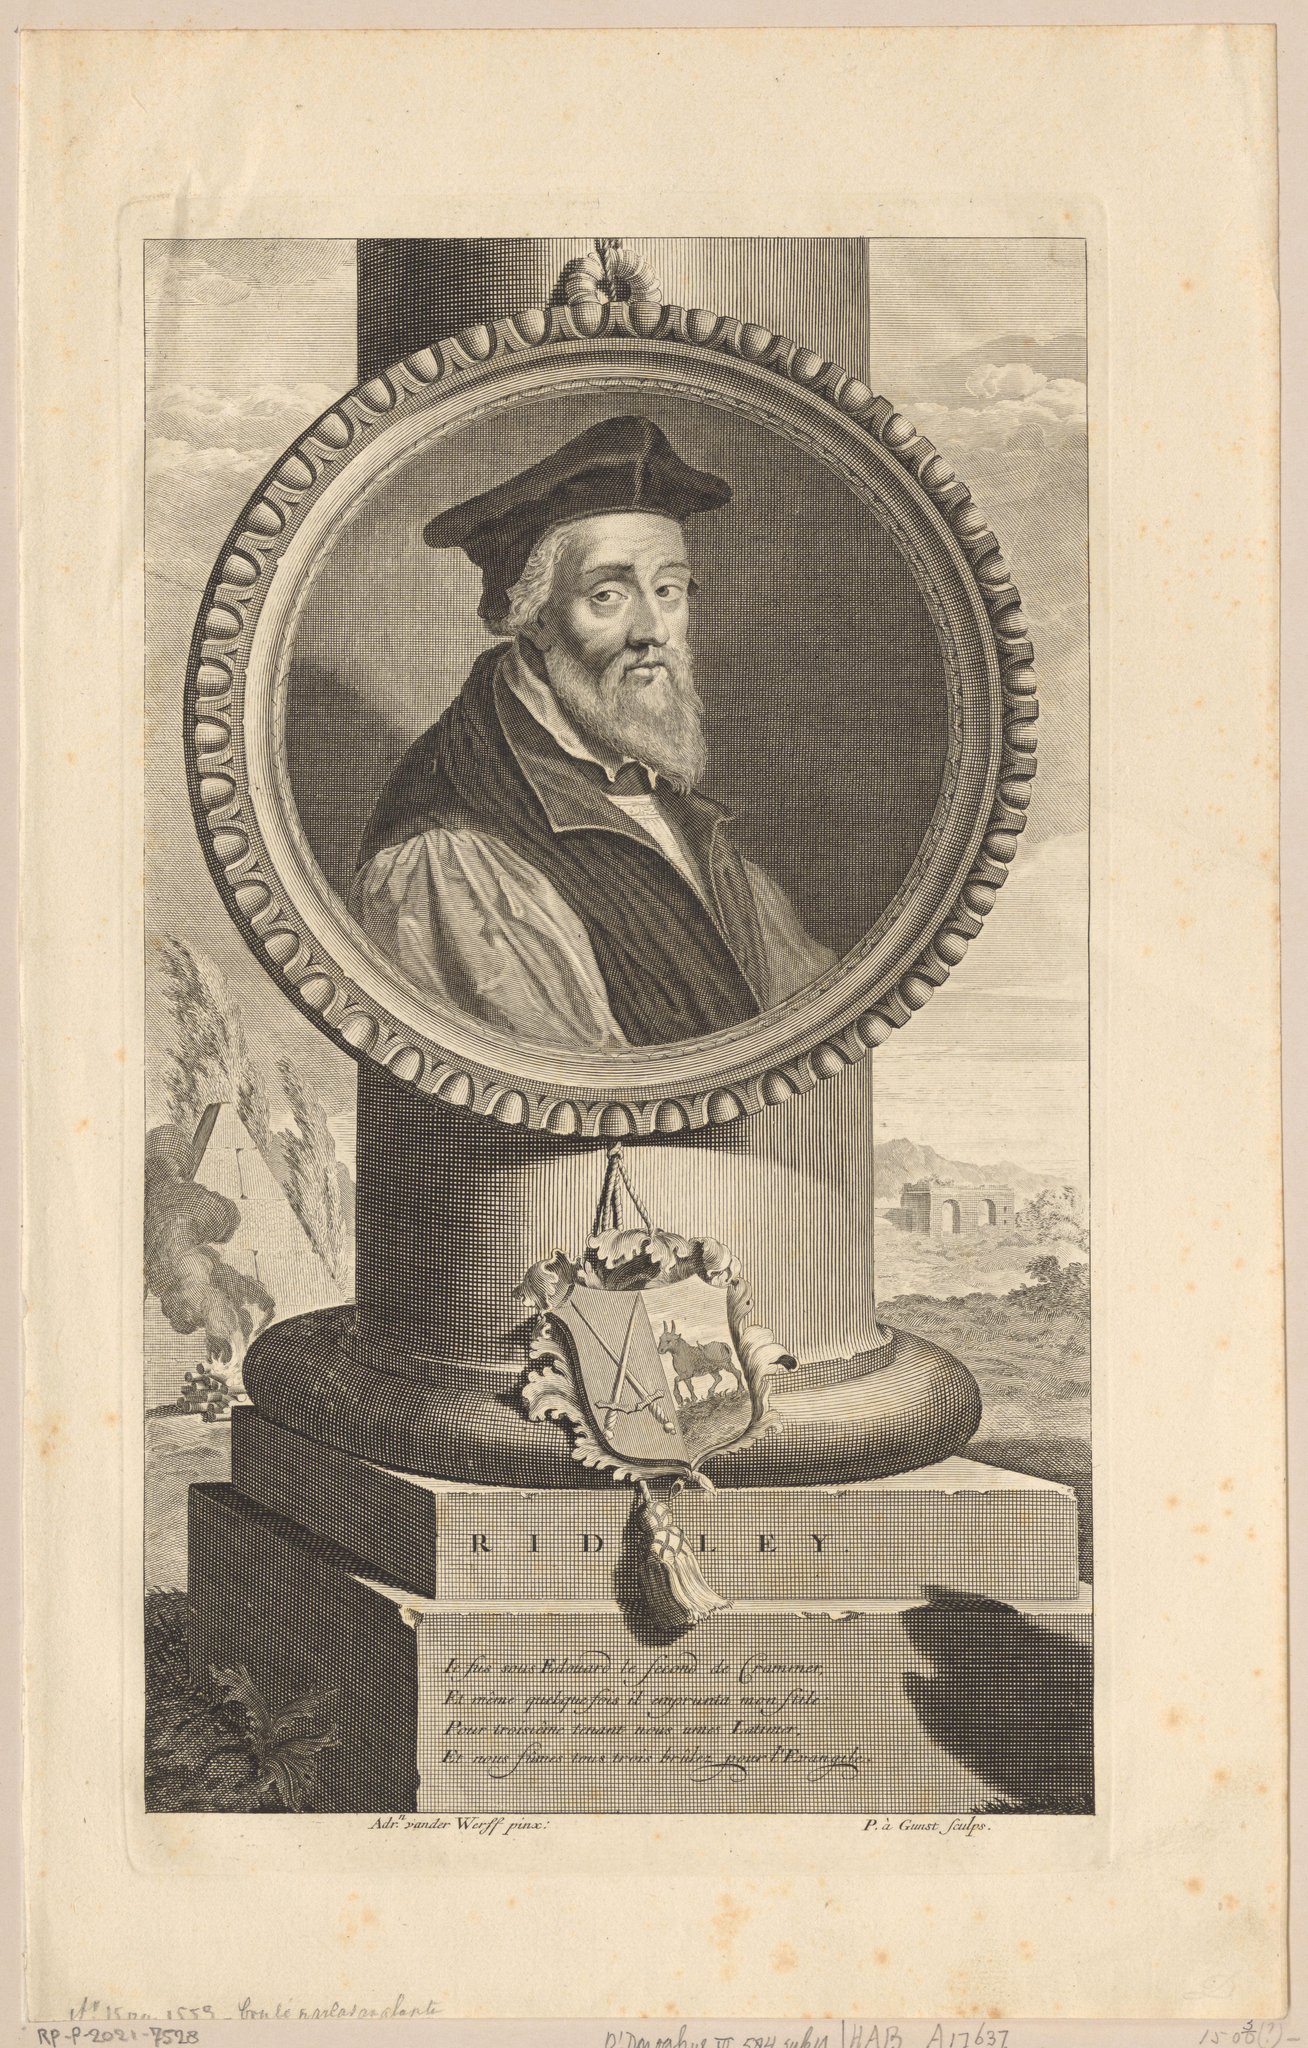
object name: print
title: Portret van Nicolas Ridley, bisschop van Londen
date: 1697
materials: paper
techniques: engraving, etching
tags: historical persons, armorial bearing, heraldry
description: Prent mogelijk uit: Larrey, Isaac de. Histoire d'Angleterre, d'Écosse, et d'Irlande (...). Rotterdam: Reinier Leers, 1697.